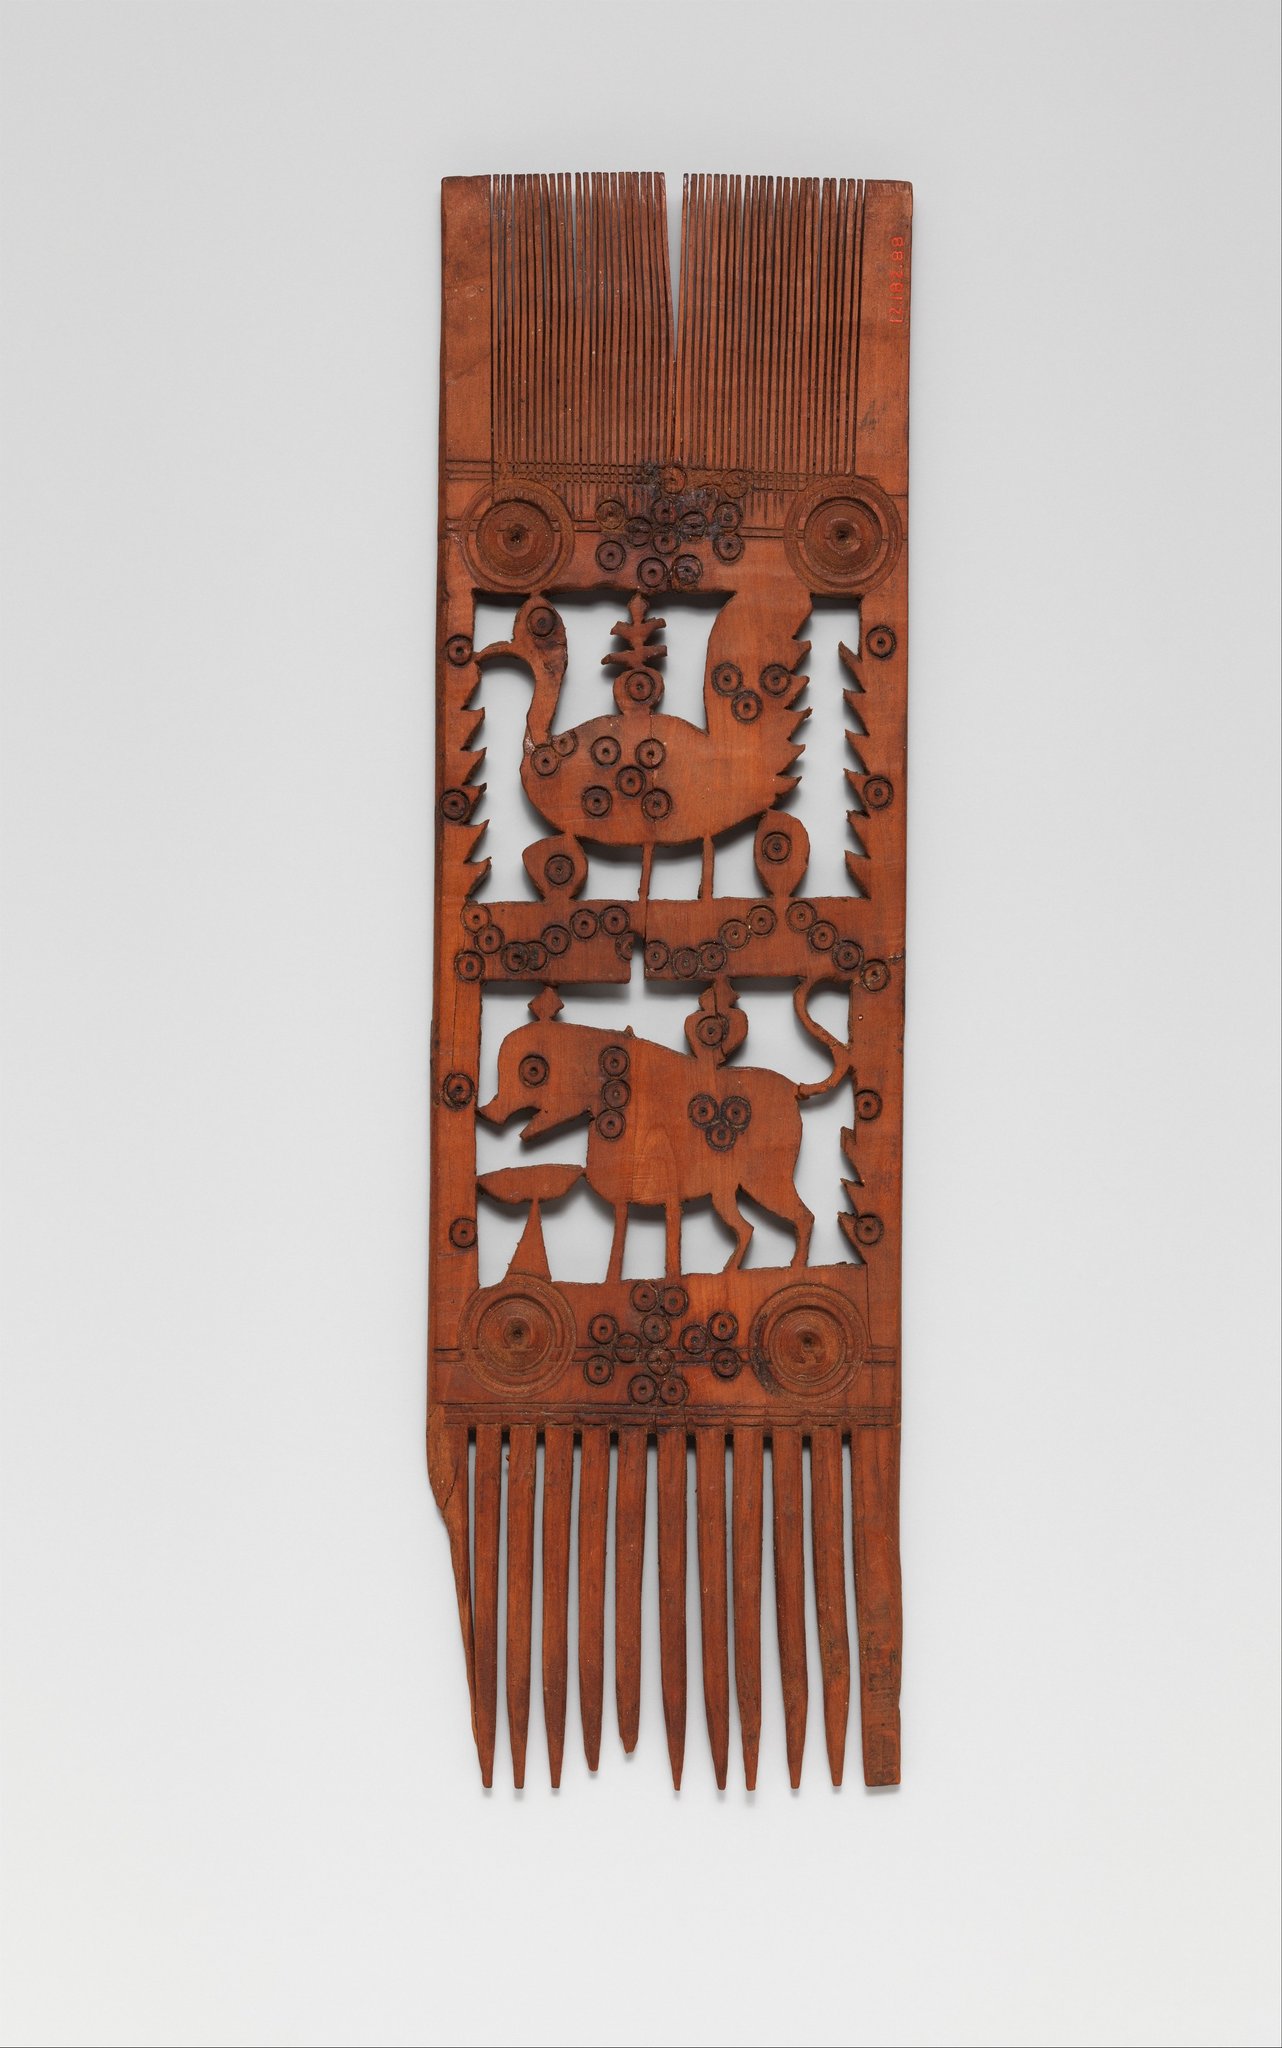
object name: comb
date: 601-700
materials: wood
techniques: carving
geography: egypt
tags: animals,birds